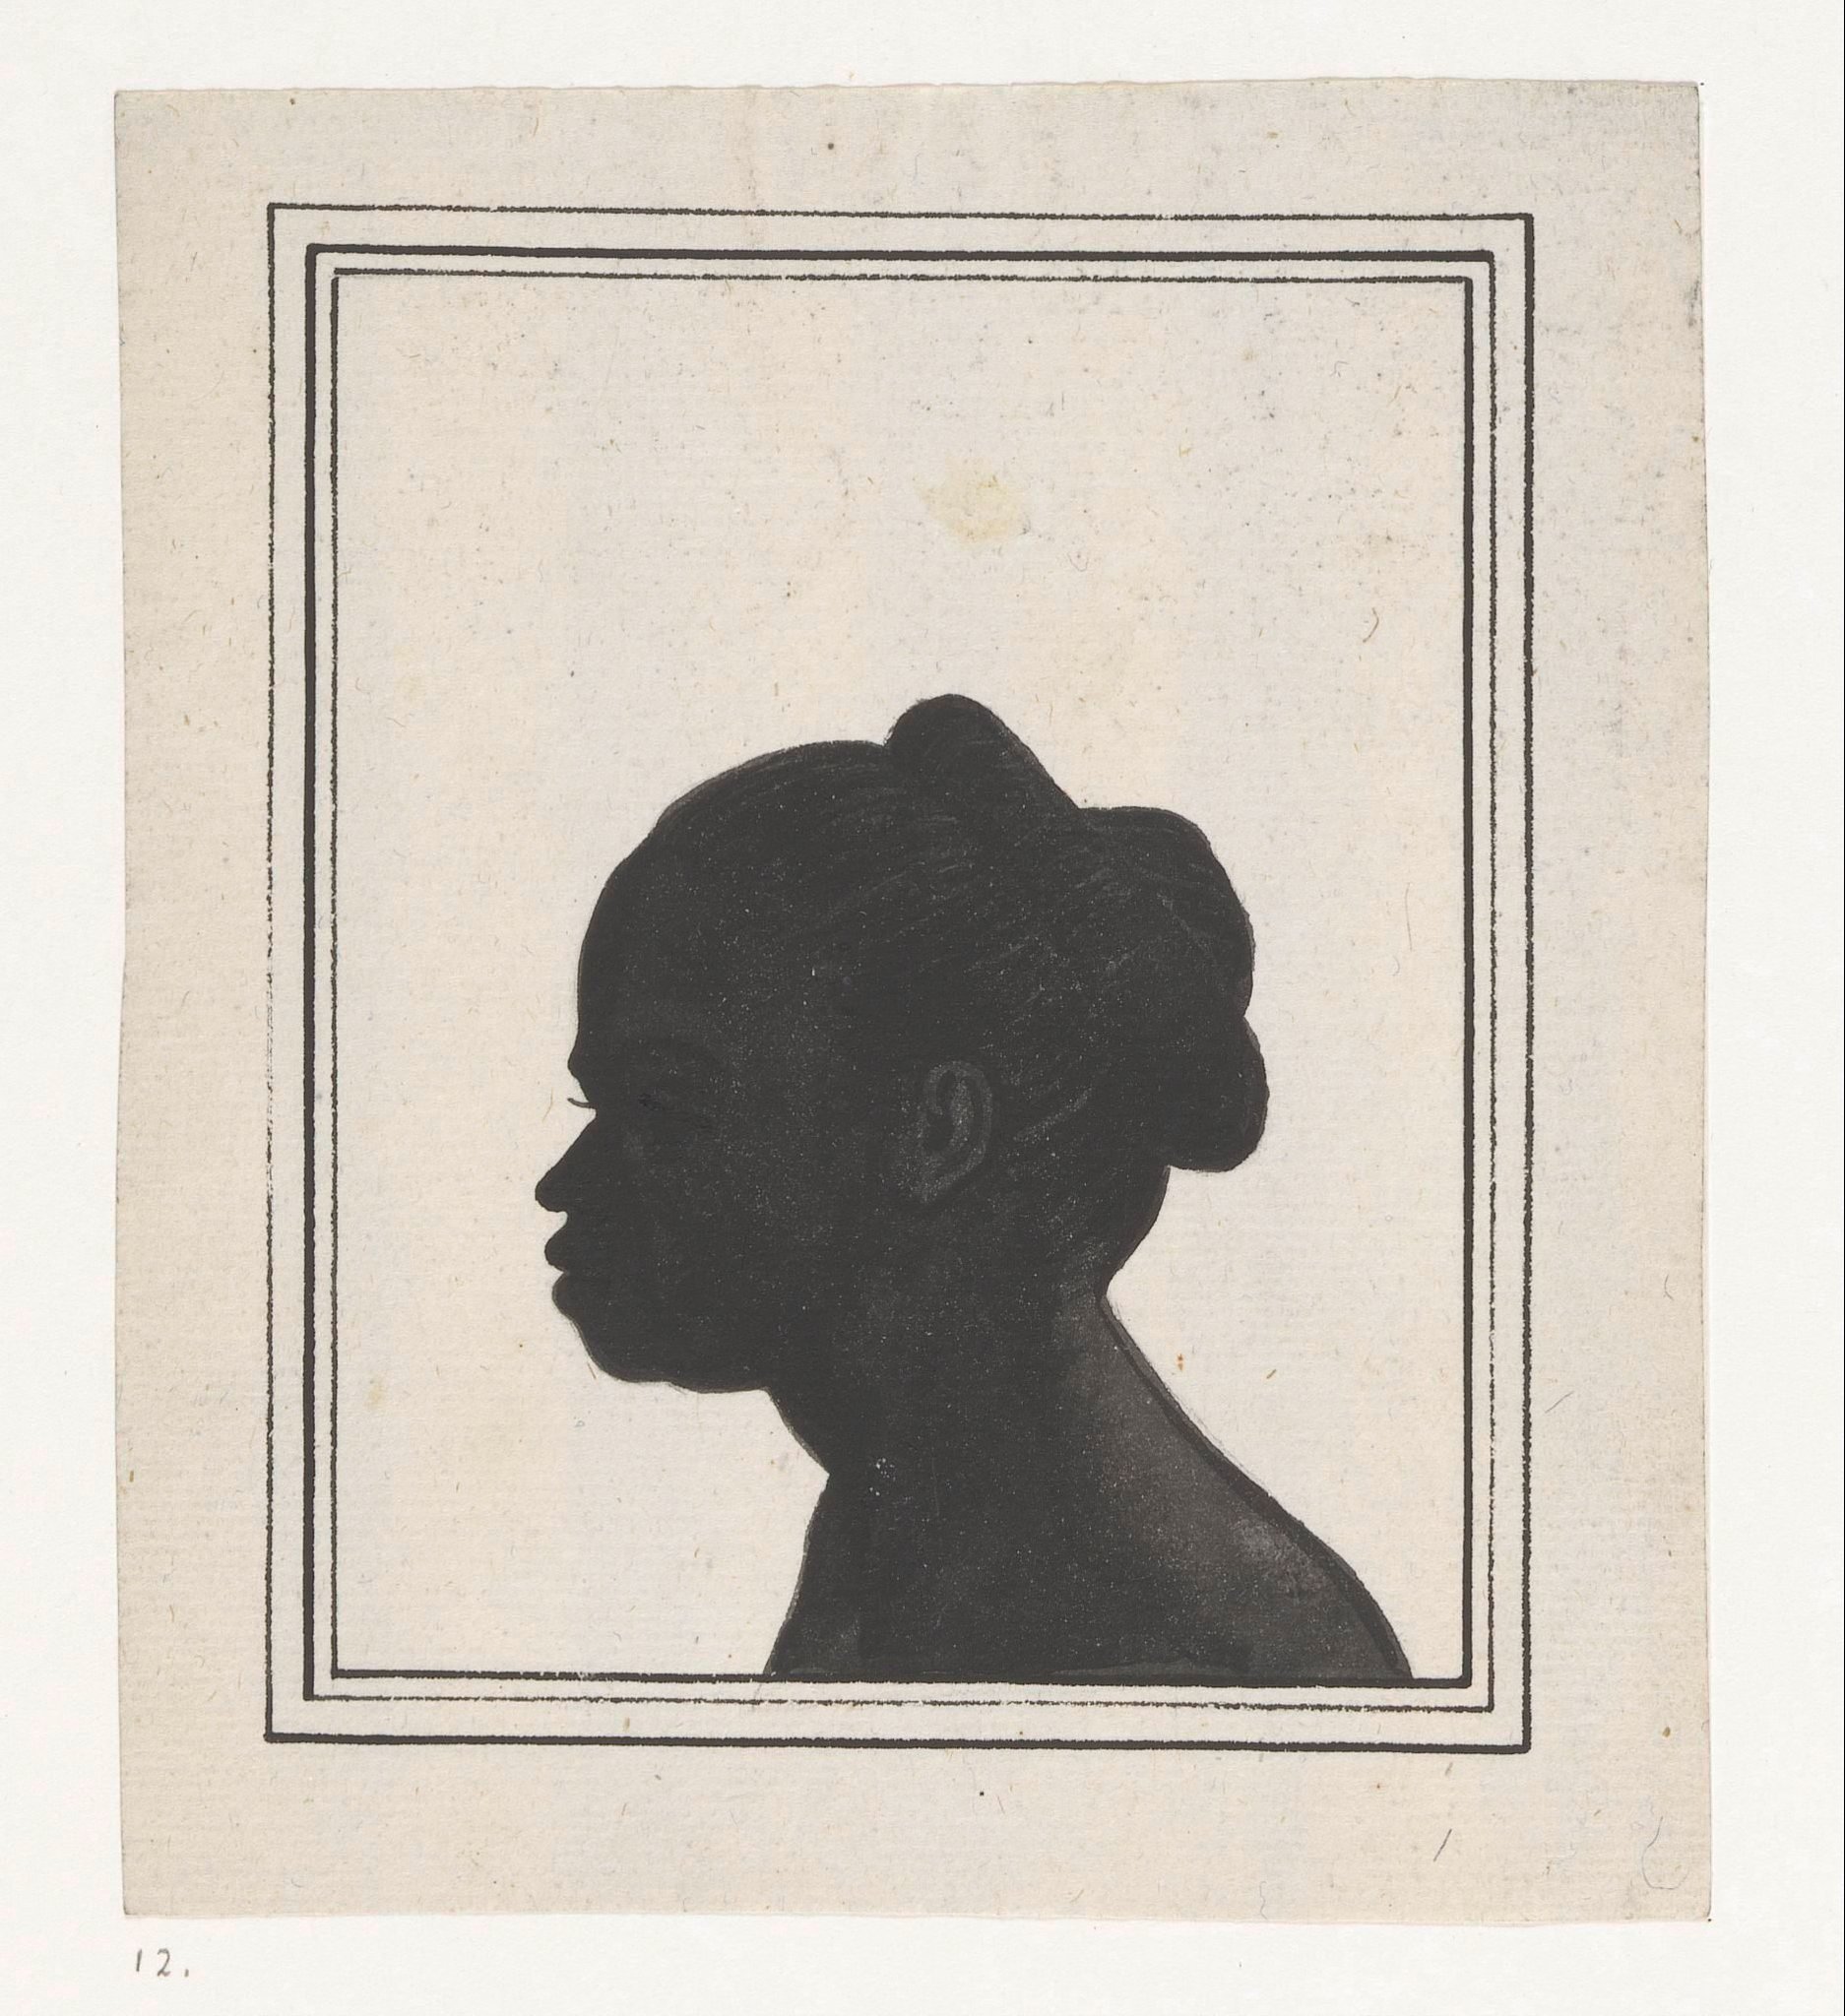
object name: drawing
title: Silhouetportret van Sara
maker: jan brandes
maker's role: draughtsman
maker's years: 1743-1808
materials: ink, paper, pencil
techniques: brush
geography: jakarta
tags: historical persons - bb - woman, slavery; serfs and enslaved persons, batavia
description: Silhouet van een borstbeeld van Sara, een tot slaaf gemaakte vrouw uit de huishouding van de tekenaar Jan Brandes in Batavia. Omkaderd.